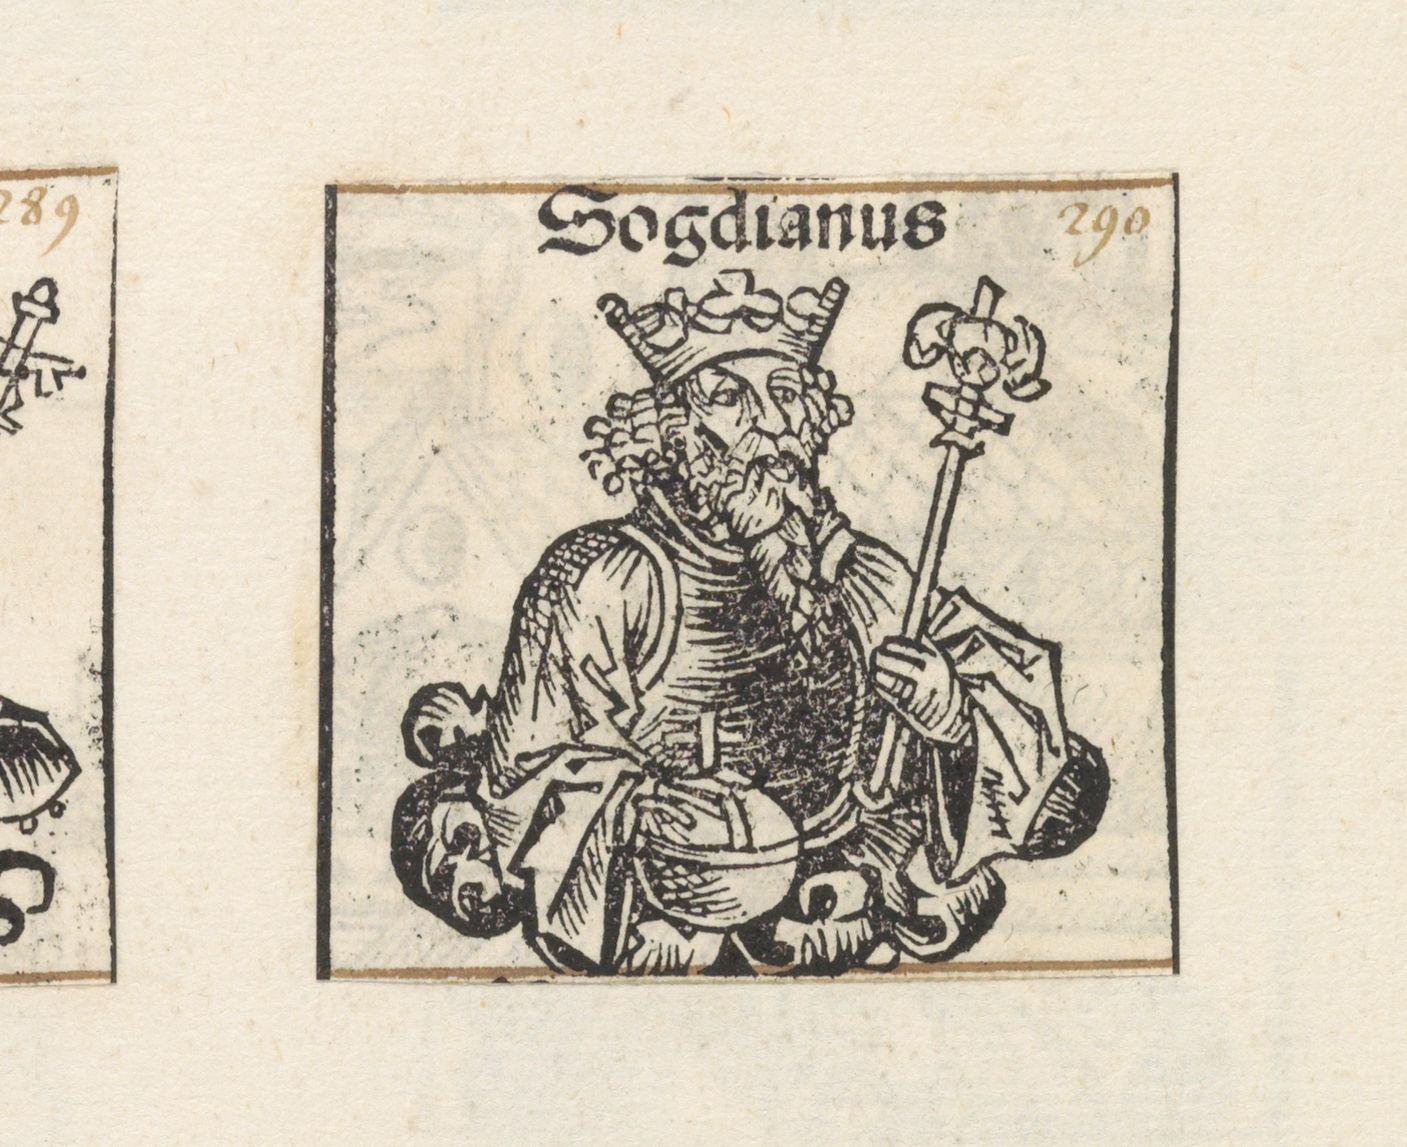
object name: album leaf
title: Sogdianus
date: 1493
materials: paper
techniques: letterpress printing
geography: nuremberg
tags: king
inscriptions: inscription: ‘290’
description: Een bloemkelk met een koning, naar rechts gericht. In zijn handen heeft hij een scepter en rijksappel. De voorstelling is onderdeel van de opeenvolging Perzische koningen in de Liber Chronicarum. De tekst identificeert de man als Sogdianus. De prent maakt deel uit van een album.